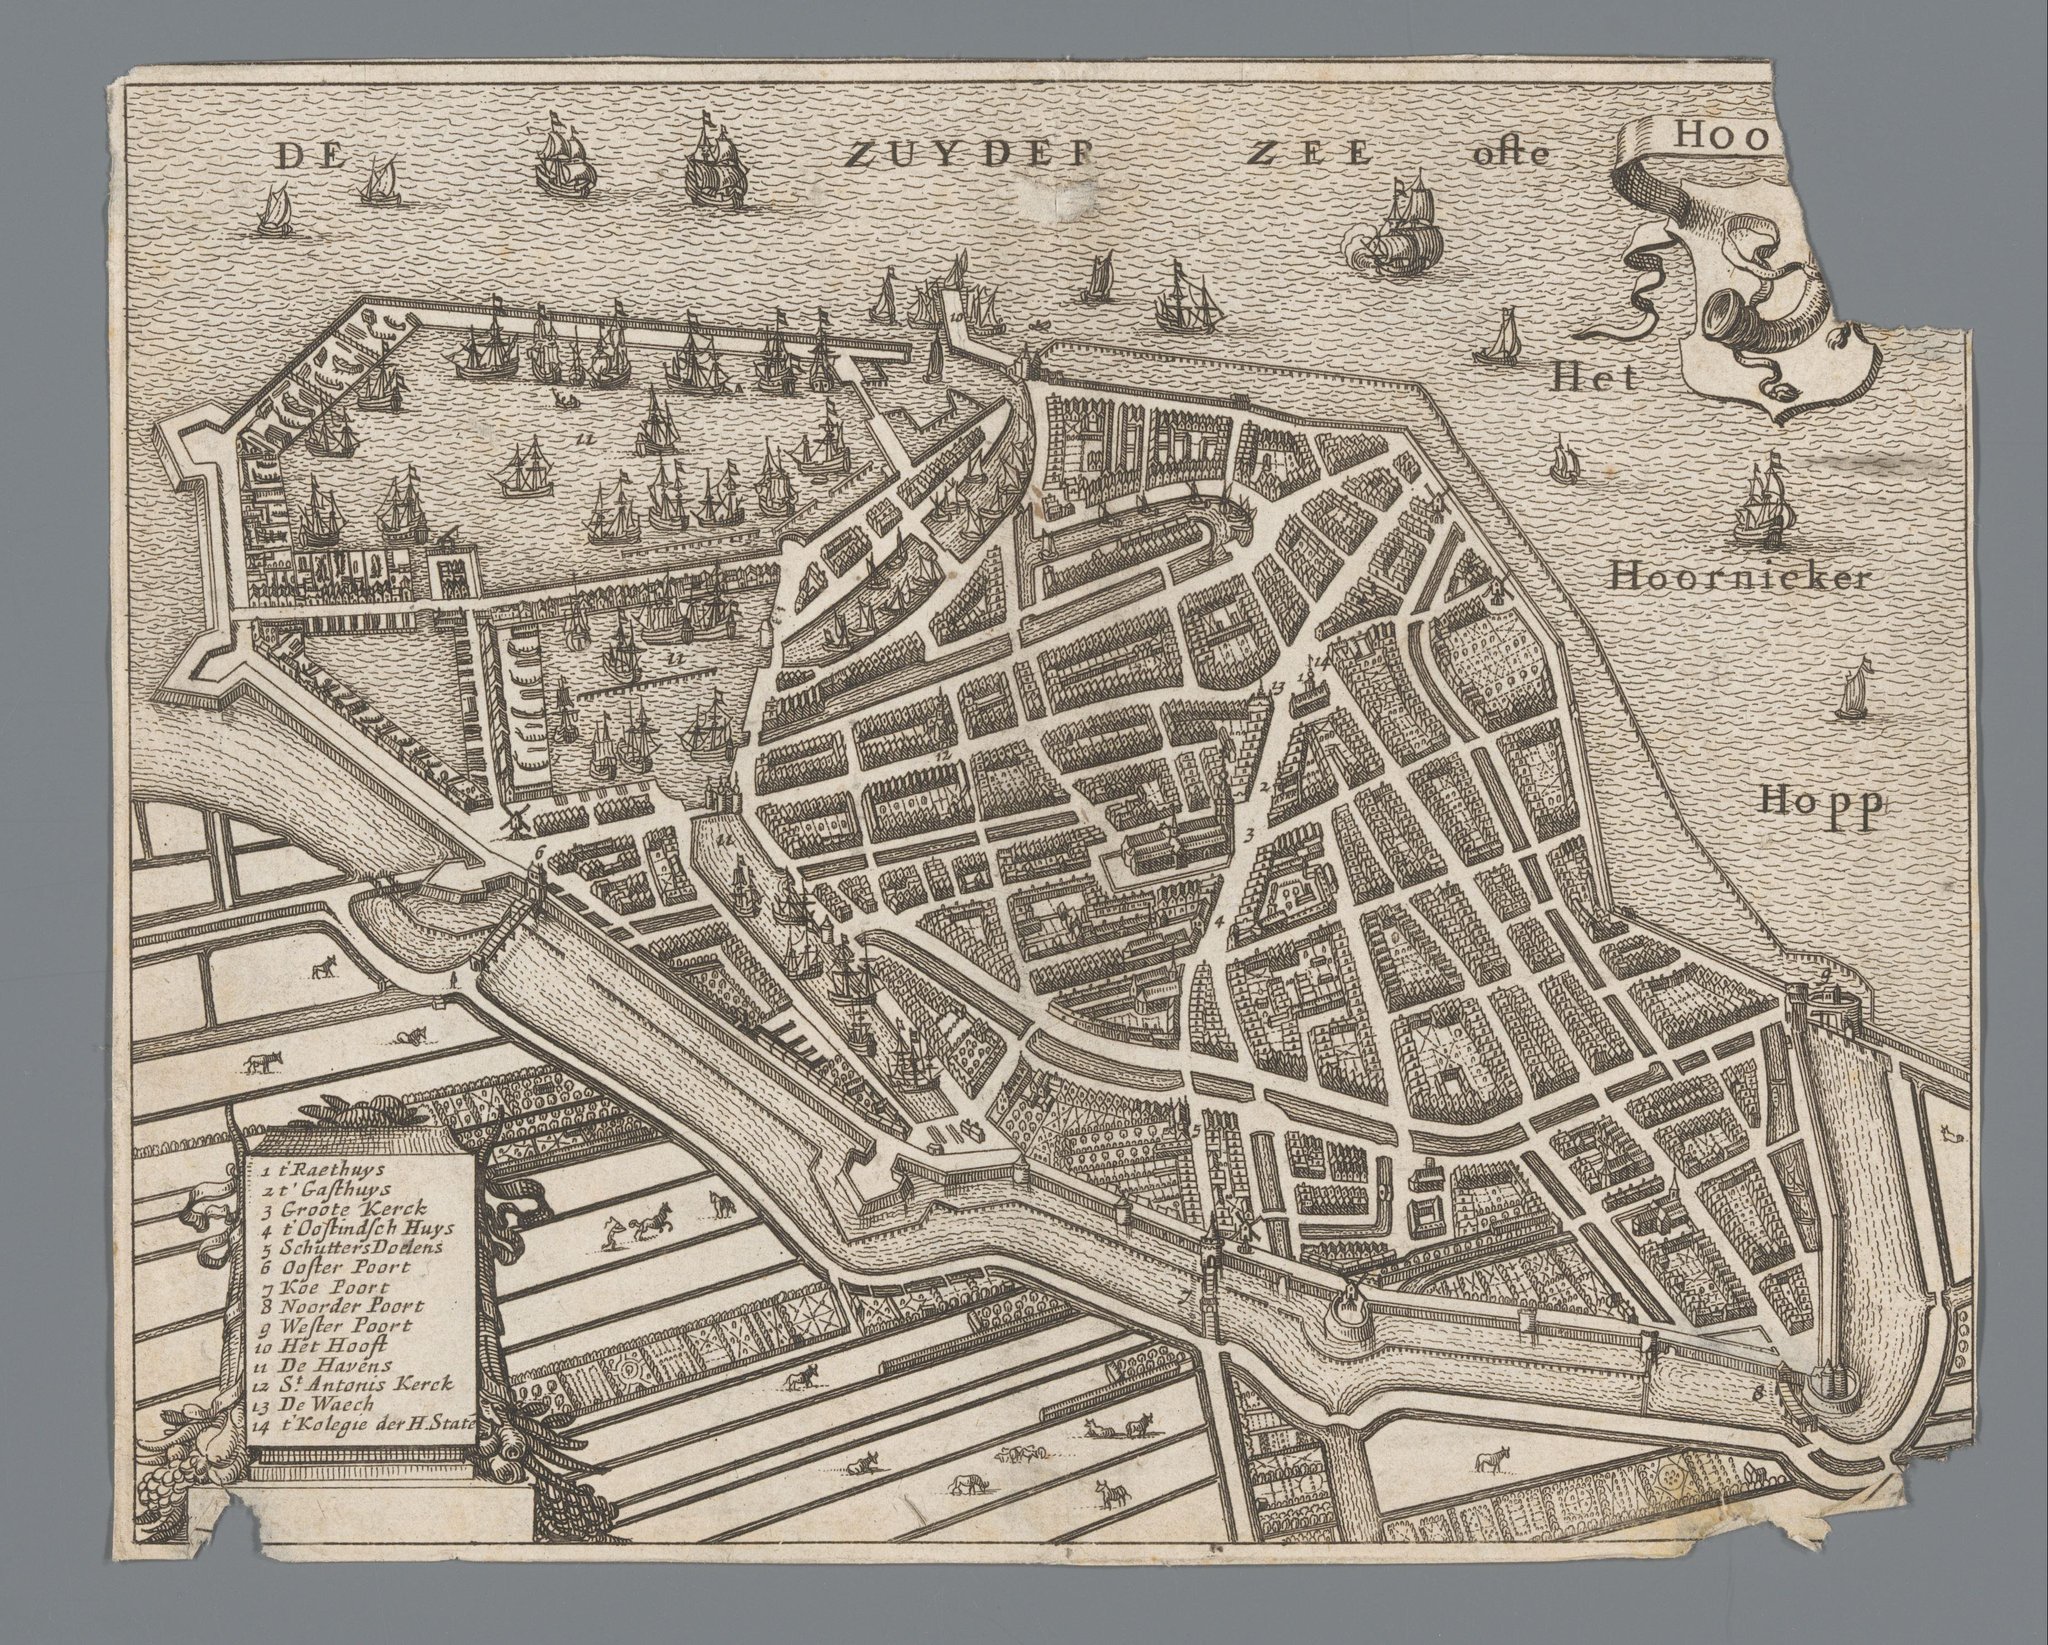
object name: area plan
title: Plattegrond van de stad Hoorn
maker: Anonymous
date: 1600-1699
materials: paper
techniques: engraving, etching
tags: maps of cities, hoorn (north holland)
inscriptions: annotation: ‘Korte beschrijving van de stad Hoorn.’